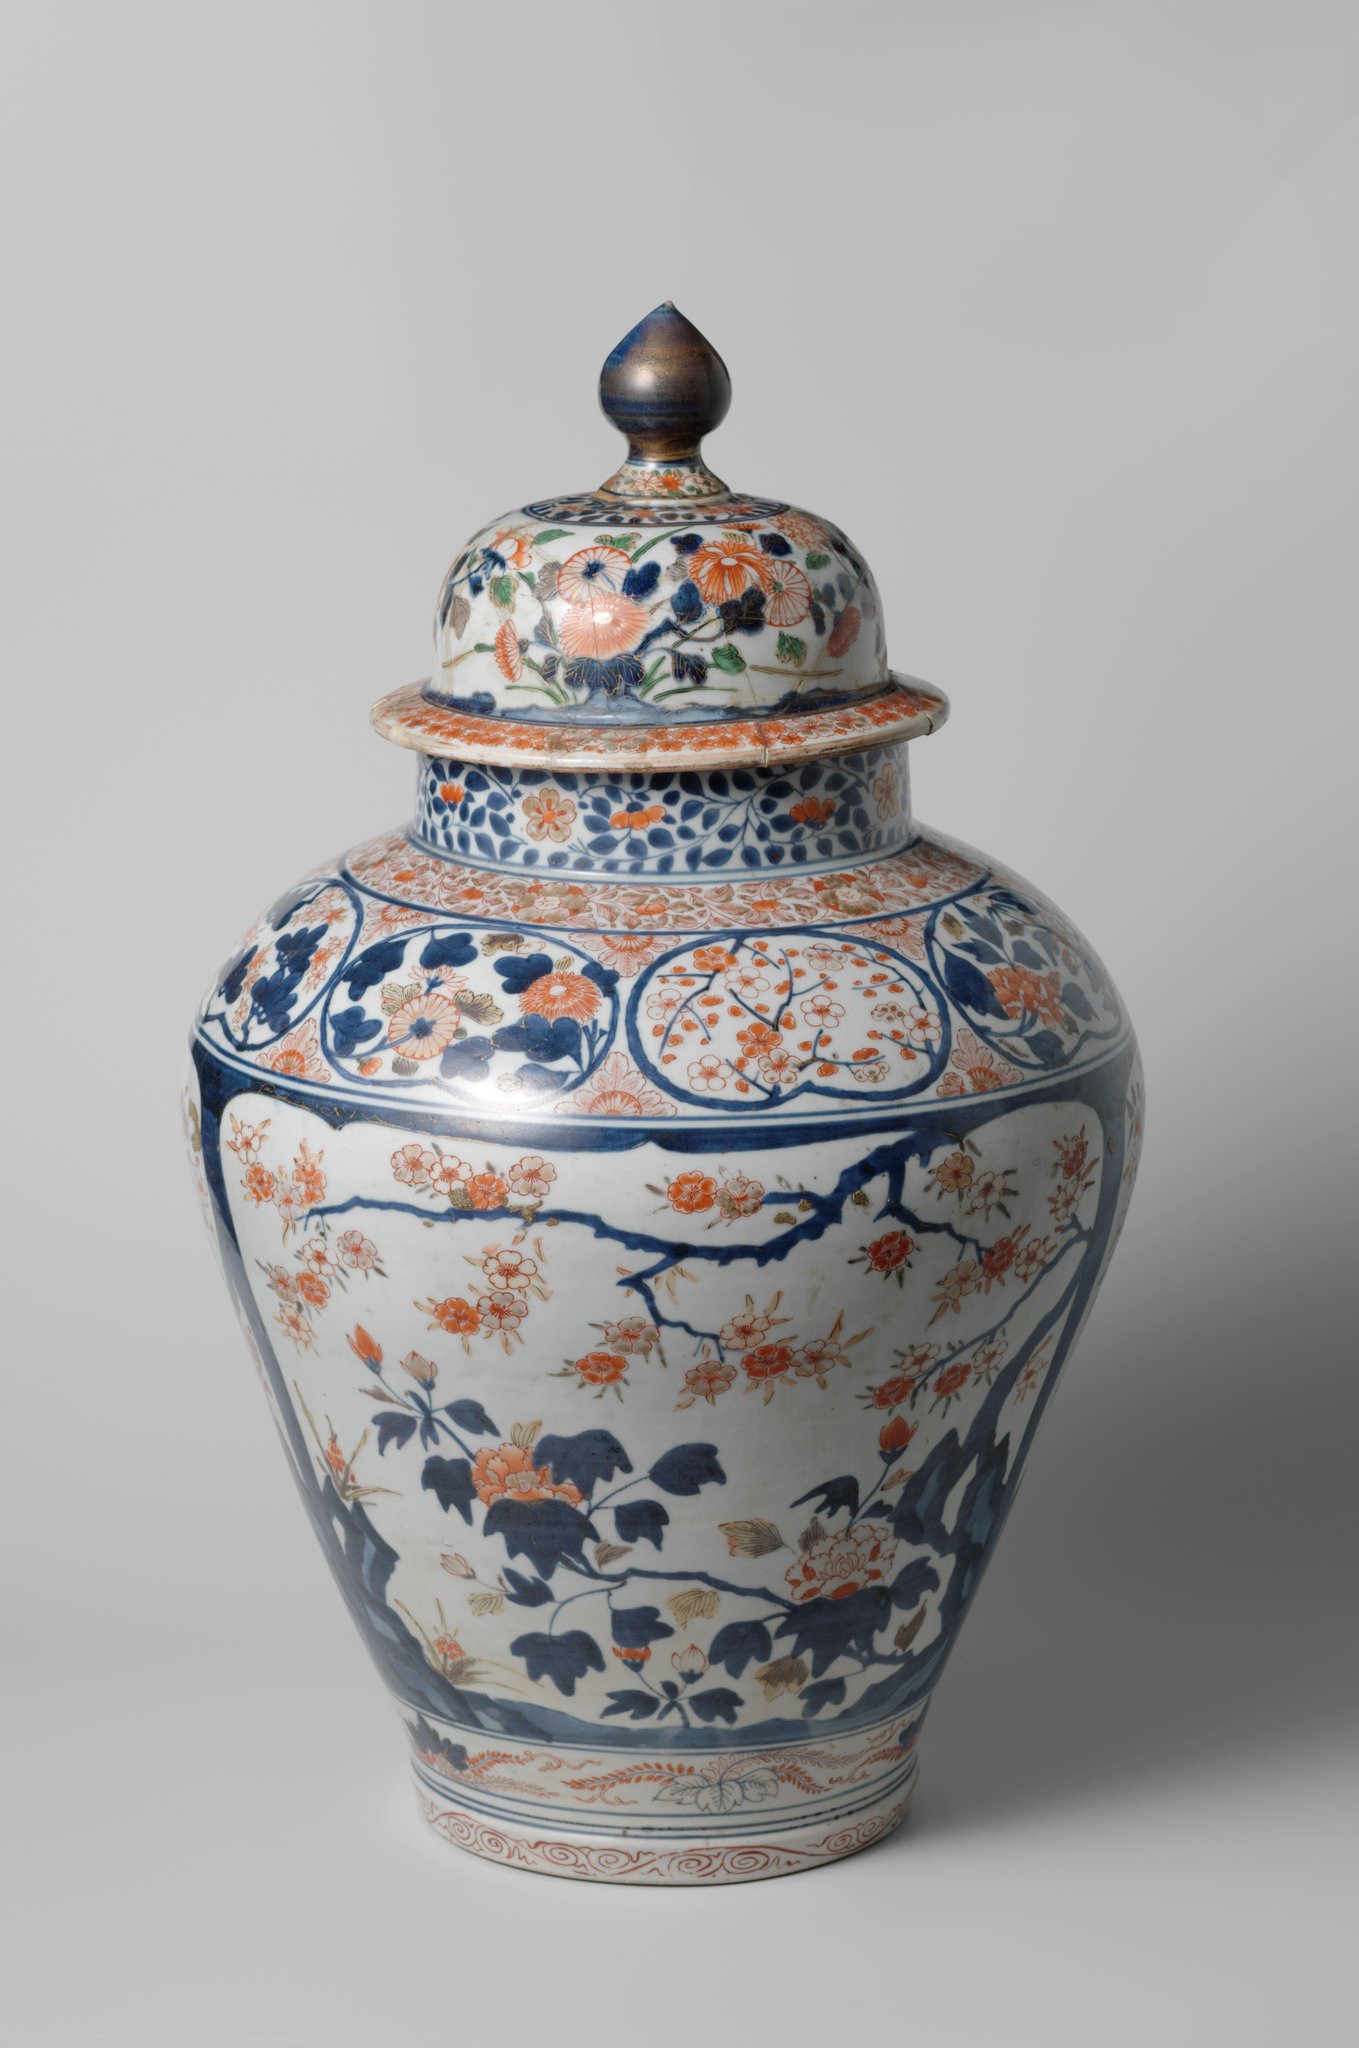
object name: covered jar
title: Covered jar with flowering plants in panels, flower sprays and scrolls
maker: Anonymous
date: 1700-1749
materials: cobalt, glaze, gold, paint, porcelain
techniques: firing, gilding, turning, vitrification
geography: japan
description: Deksel van balustervormige dekselpot van porselein, beschilderd in onderglazuur blauw en op het glazuur rood, groen en goud. De deksel is beschilderd met bloeiende planten bij rotsen (hortensia, pioen, chrysant) met rond de knop twee banden met bloemranken. De rand met een band bloemen. Deksel is gebroken geweest en waarschijnlijk niet origineel bij de pot. Imari.